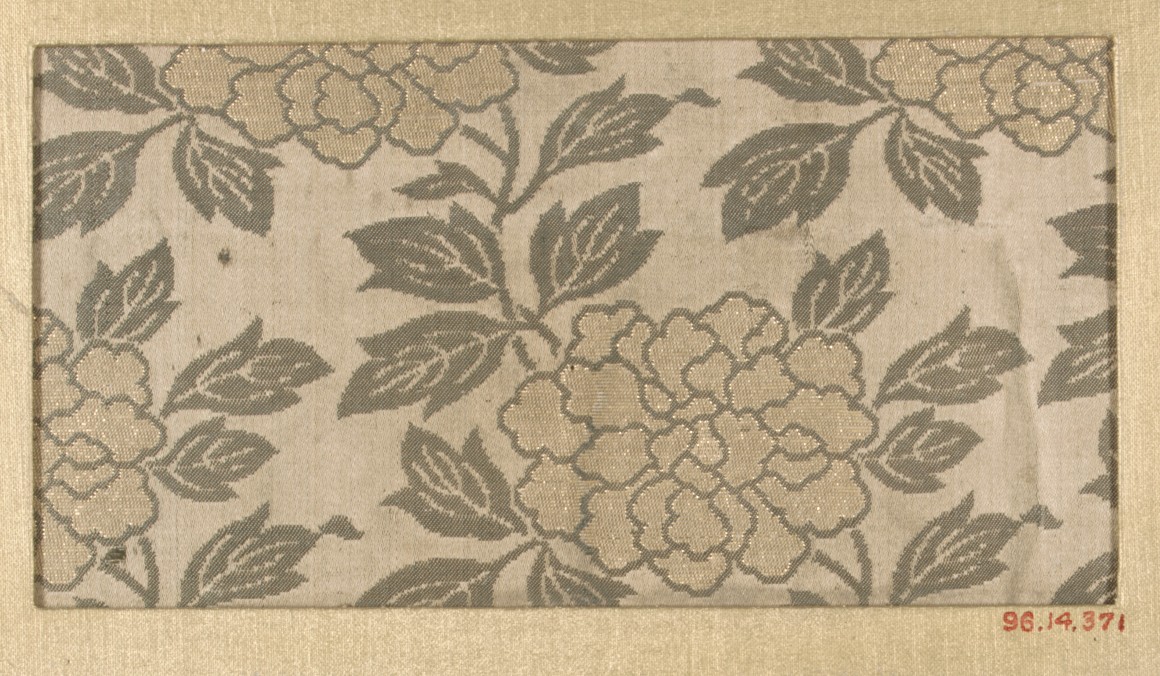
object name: piece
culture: japanese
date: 1701-1900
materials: silk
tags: leaves